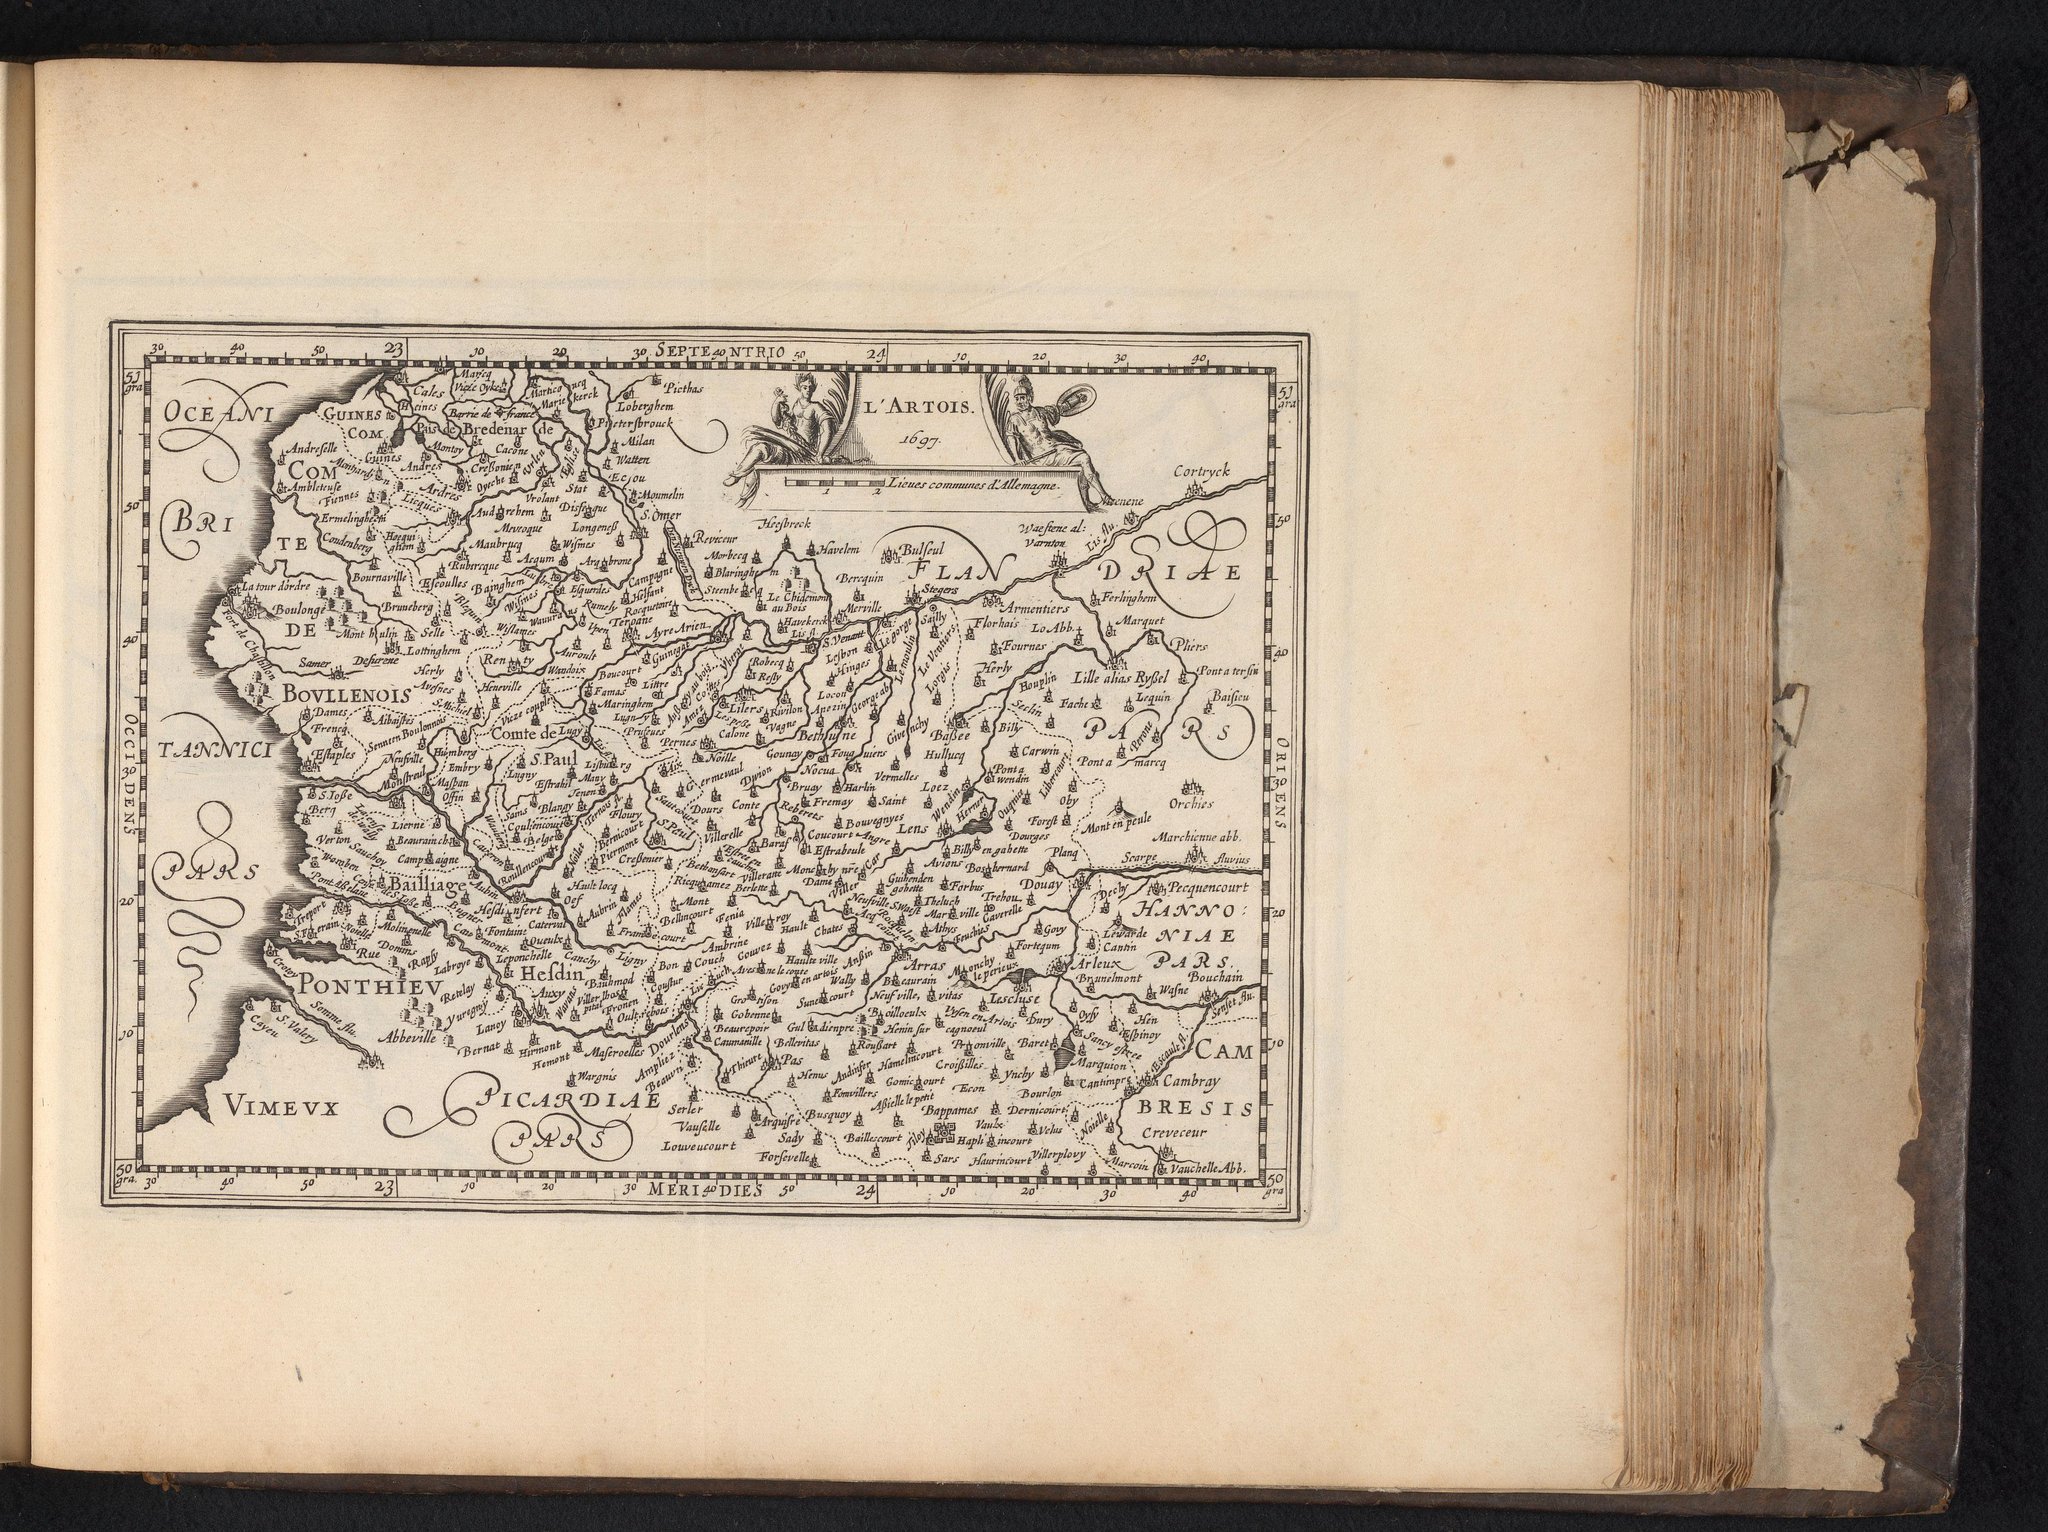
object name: map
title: Le theatre de la guerre, dans les Pays-Bas, ou representation des principales villes qui sont en Flandre, Hainaut, Brabant, et c. : avec leurs fortifications : dessignées par les meilleurs ingenieurs, particulierement celles (...) dont les plans ont esté levez par M. de Vauban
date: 1697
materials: paper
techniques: engraving, etching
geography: paris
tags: maps of separate countries or regions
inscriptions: date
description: Kaart van het graafschap Artesië (Artois). Onderdeel van het eerste van twee delen van het prentwerk: Le Theatre de la Guerre, dans les Pays-Bas, waarvan het titelblad uitgegeven is in 1696. Aangezien deze kaart 1697 is gedateerd, moeten deze kaart (en de inhoudsopgave) later aan de oorspronkelijke bundel uit 1696 zijn toegevoegd. Het prentwerk bestaat in totaal (beide delen) uit 52 platen met plannen (afkomstig van Sébastien Le Prestre, Seigneur de Vauban) van vermaarde sterke steden en vestingen in de Negenjarige Oorlog in de Nederlanden. Titel en opschriften in het Frans.